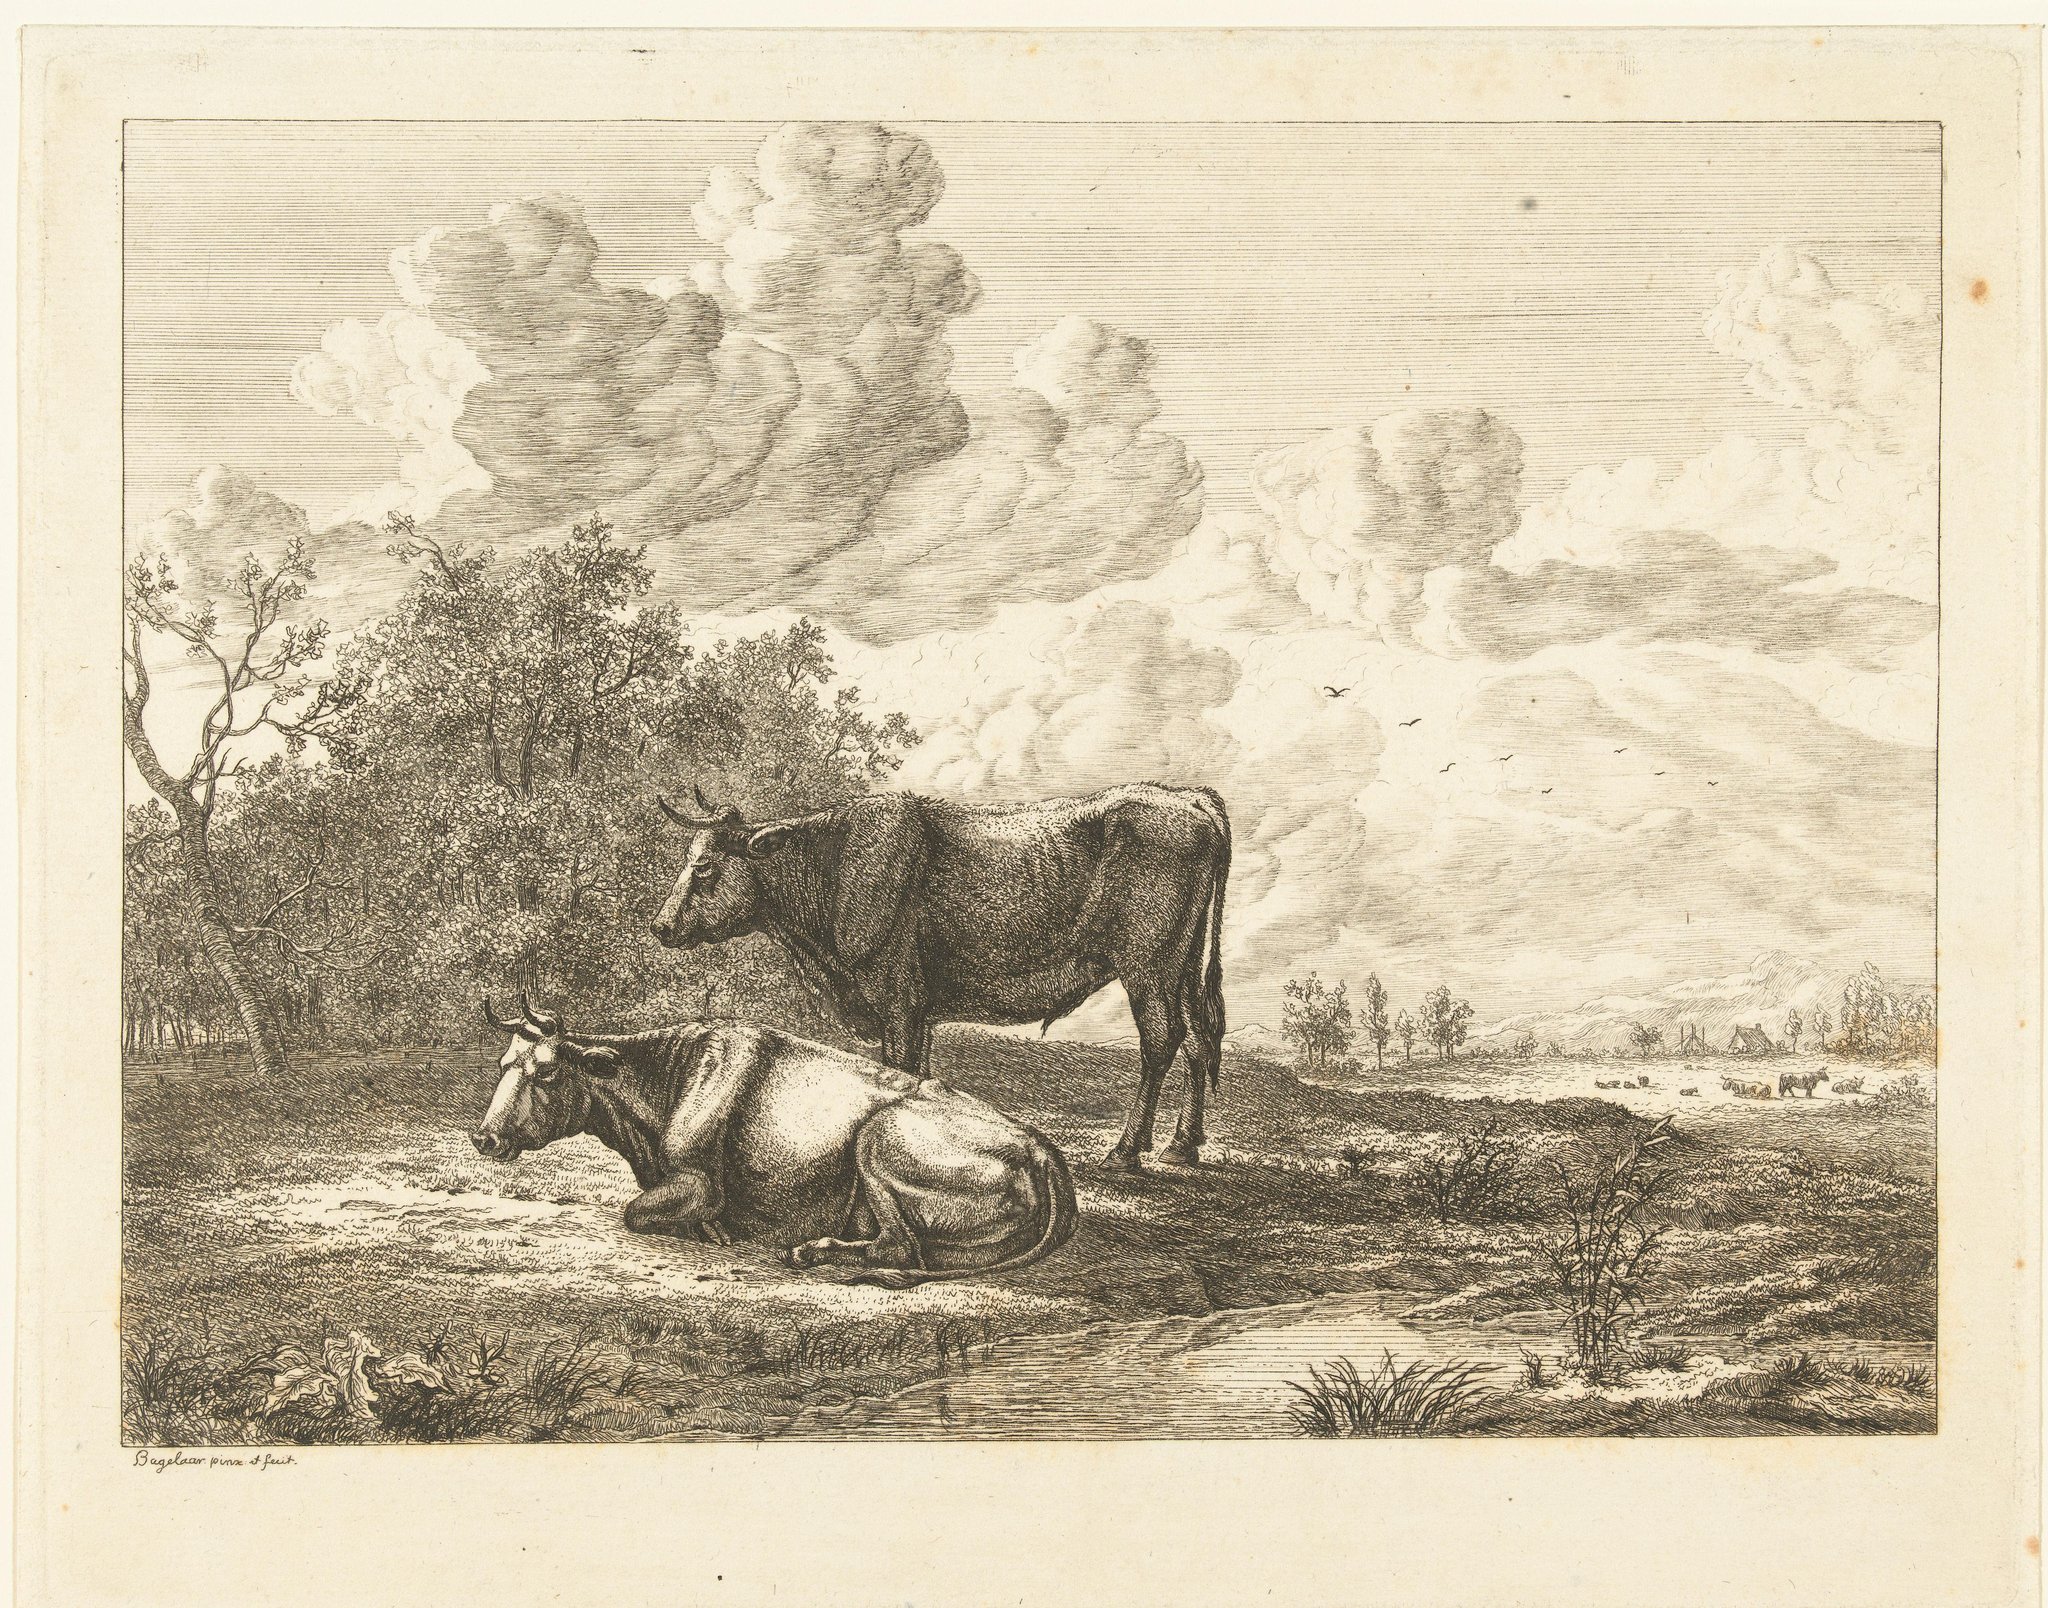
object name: print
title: Een stier en een koe in een weiland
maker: ernst willem jan bagelaar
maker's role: draughtsman, print maker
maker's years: 1775-1837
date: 1798-1837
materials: paper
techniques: drypoint, etching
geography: netherlands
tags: bovine cattle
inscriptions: collector's mark: Lugt 2228